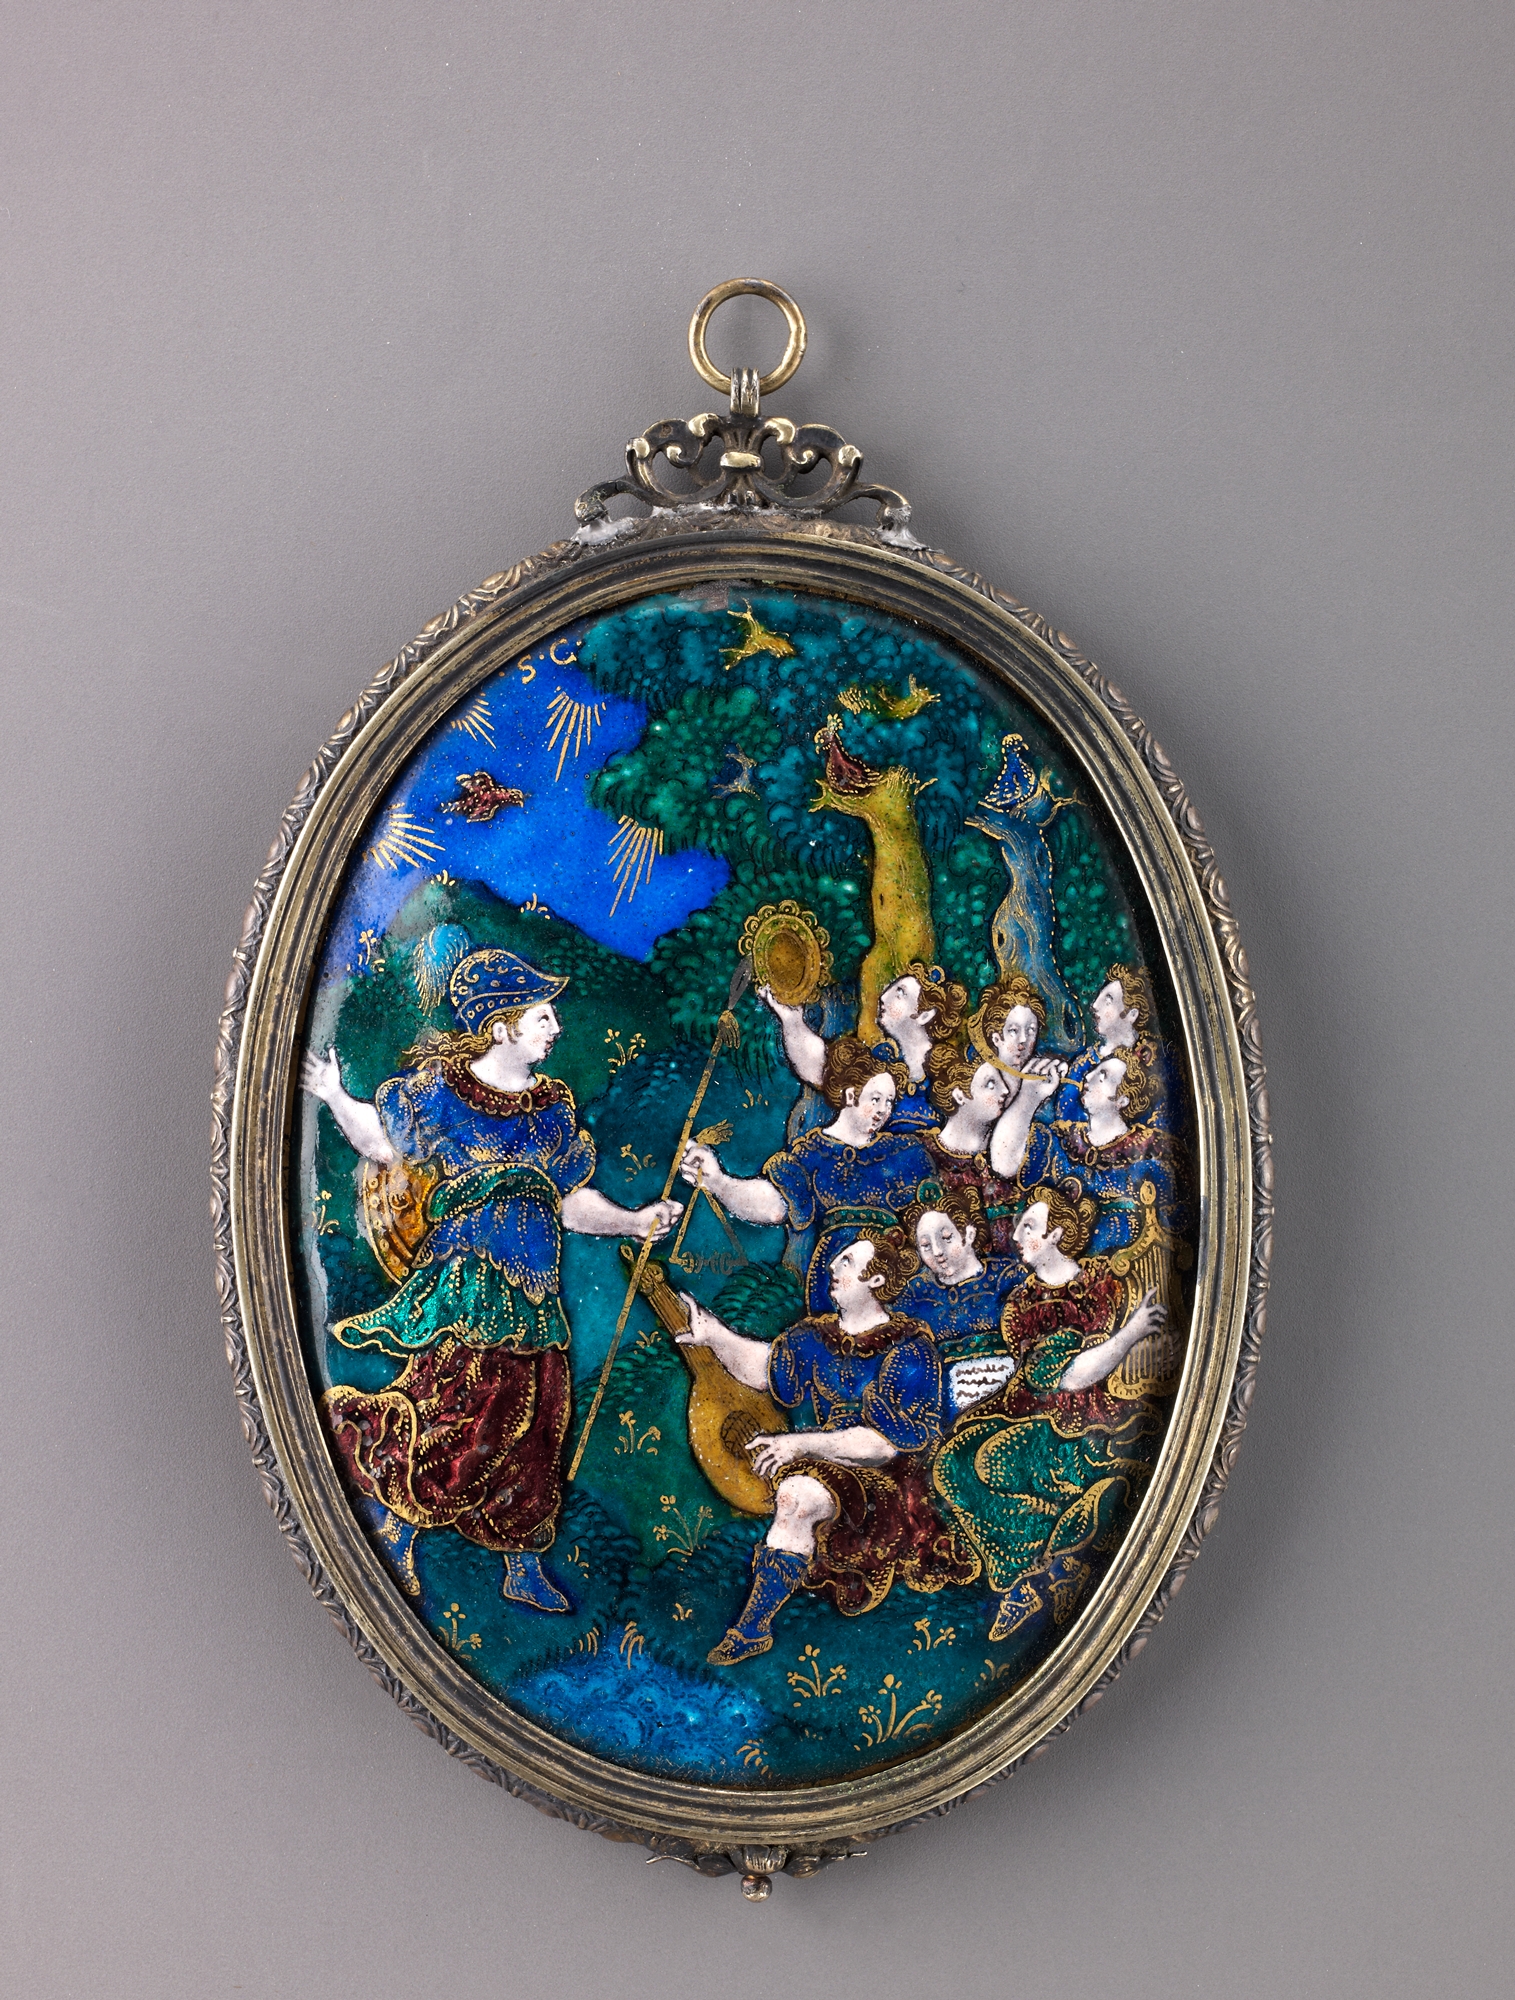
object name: mirror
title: Mirror; Minerva Visits the Muses on Mount Helicon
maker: suzanne de court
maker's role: artist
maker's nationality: french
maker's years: 1575-1625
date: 1601-1633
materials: copper, enamel, gilt, glass, silver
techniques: painting, silvered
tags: minerva,muses